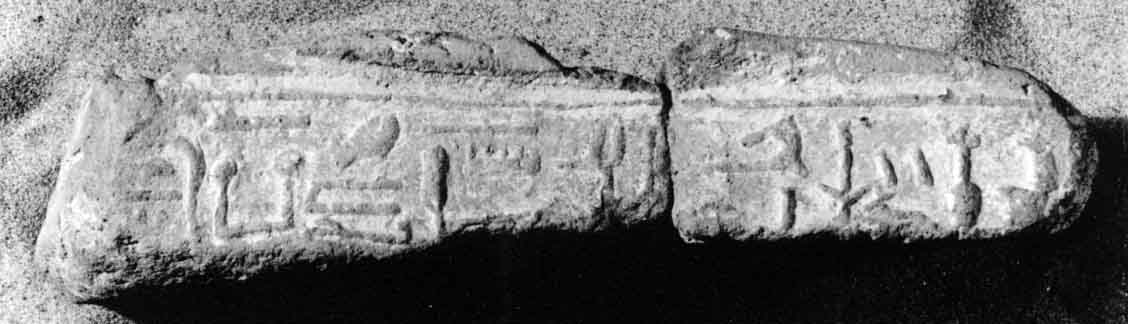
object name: cone, stamped brick, userhat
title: Stamped Brick of Userhat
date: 1550-1295 BCE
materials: pottery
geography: egypt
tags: hieroglyphs